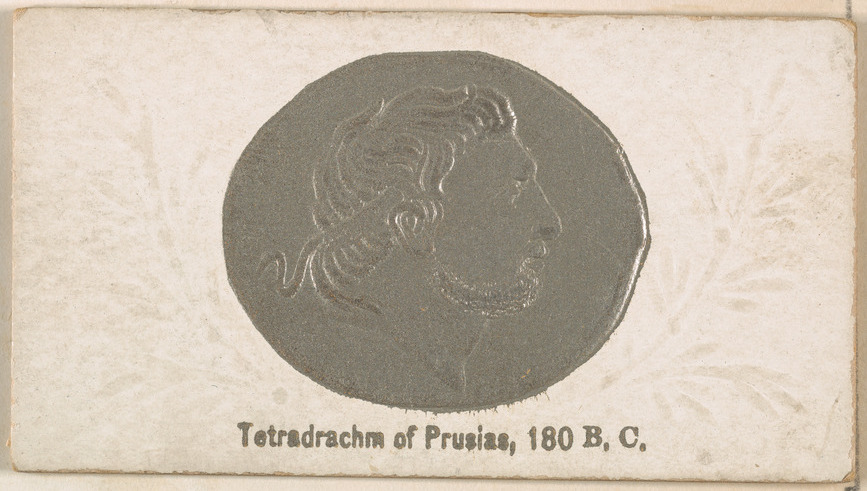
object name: print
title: Tetradrachm of Prusias, 180 B.C., from the Ancient Coins series (N180) issued by Wm. S. Kimball & Co.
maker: william s. kimball & company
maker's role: publisher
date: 1888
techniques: color lithograph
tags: men,coins